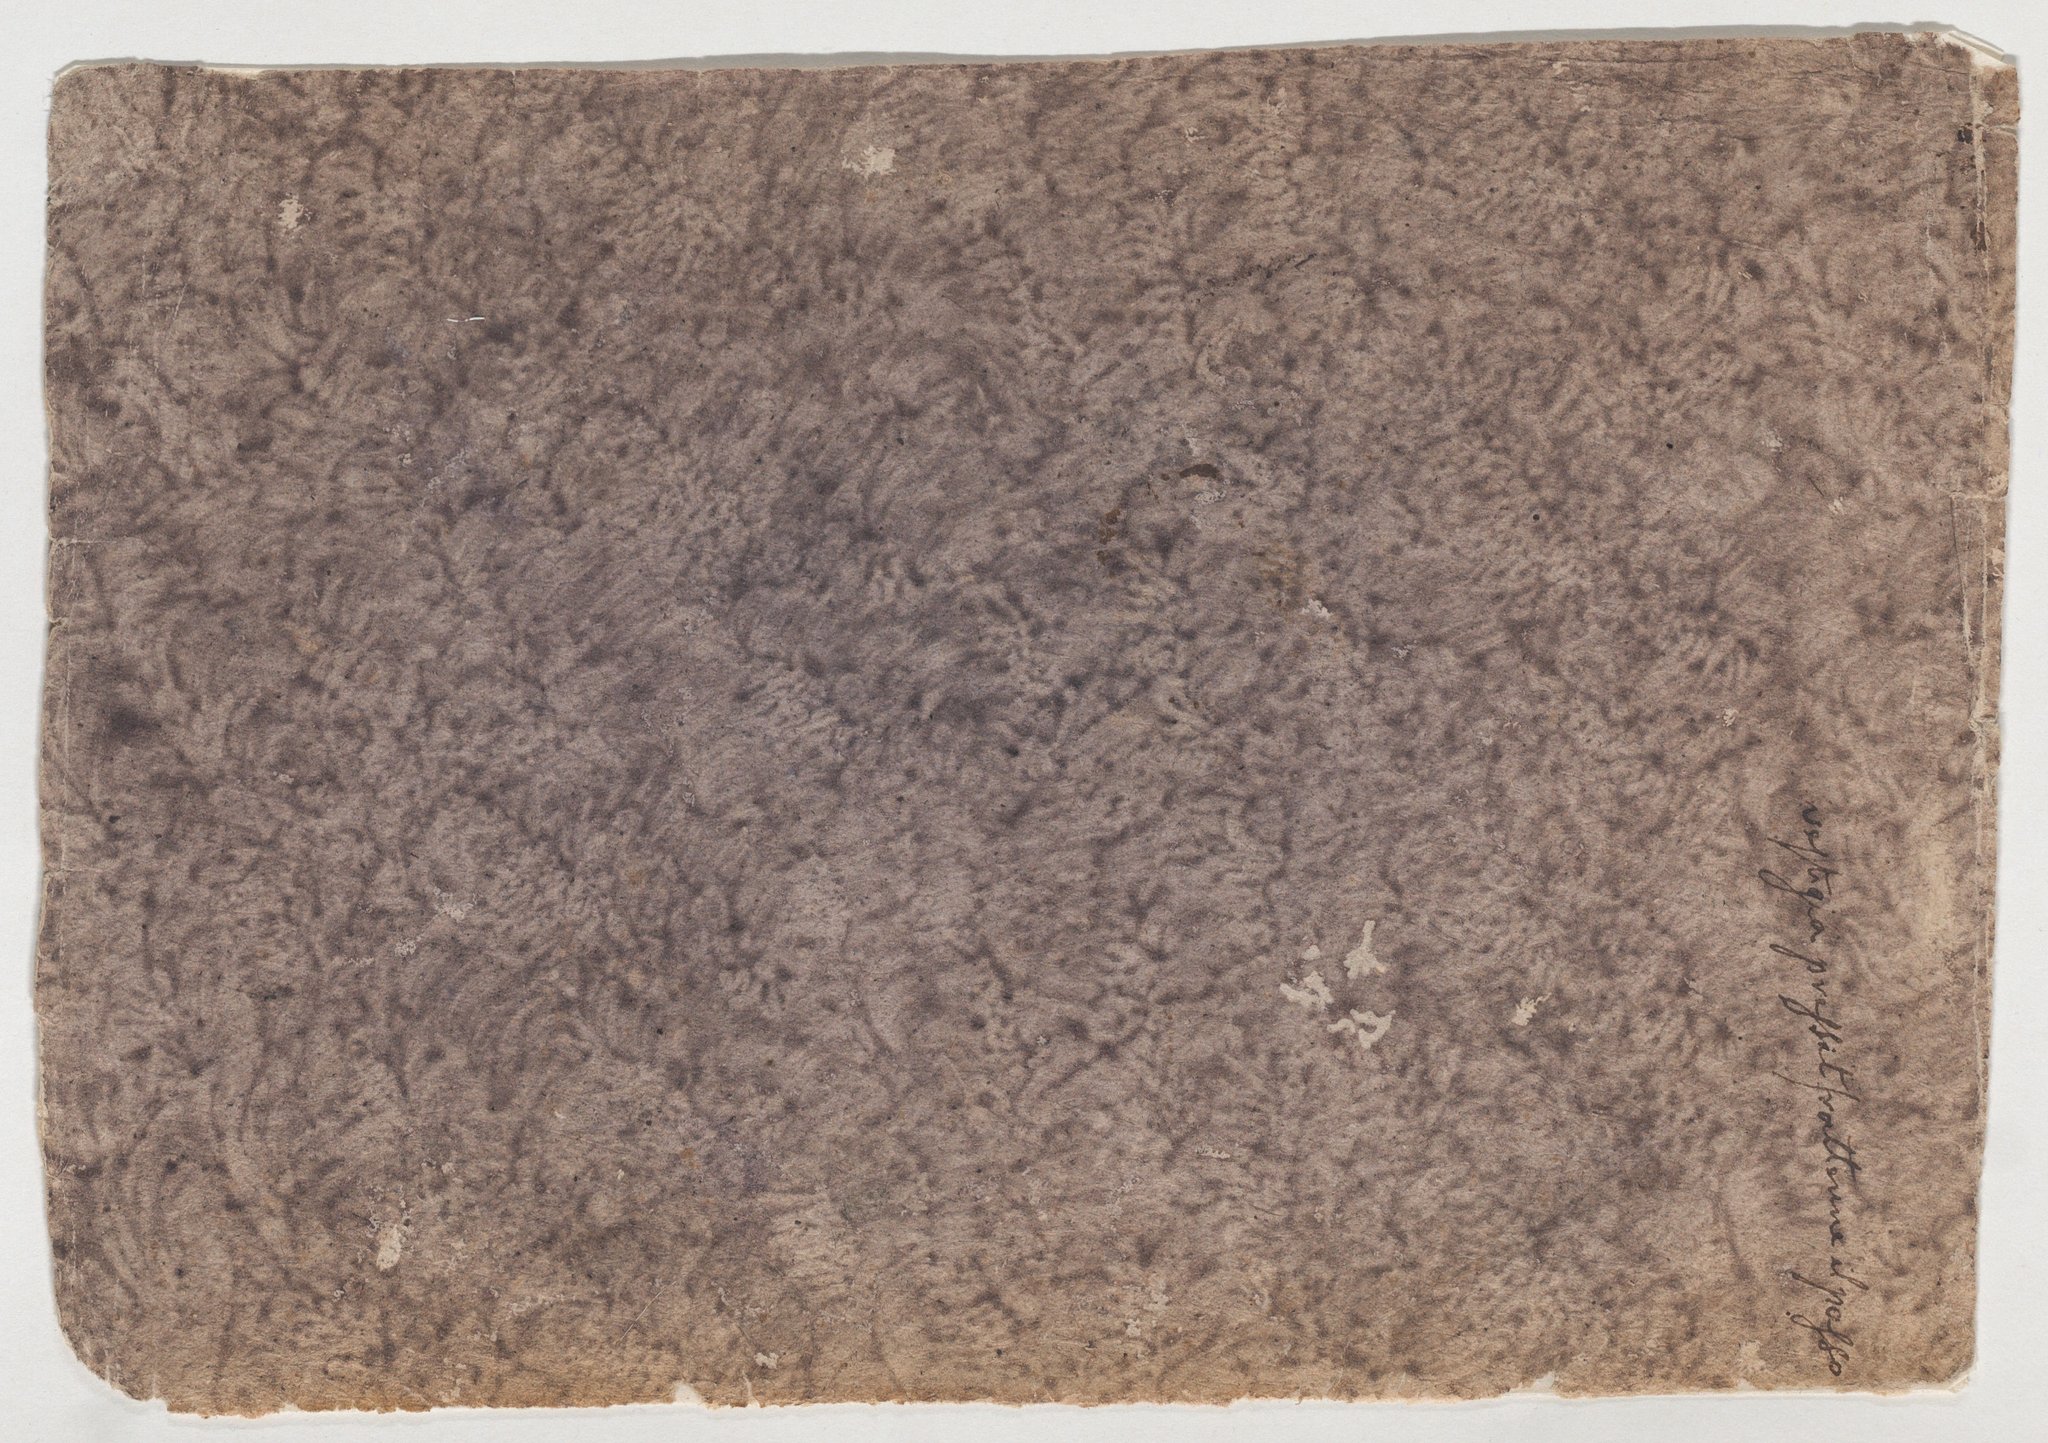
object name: print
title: Gray paste paper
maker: Anonymous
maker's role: artist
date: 1701-1800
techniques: relief print